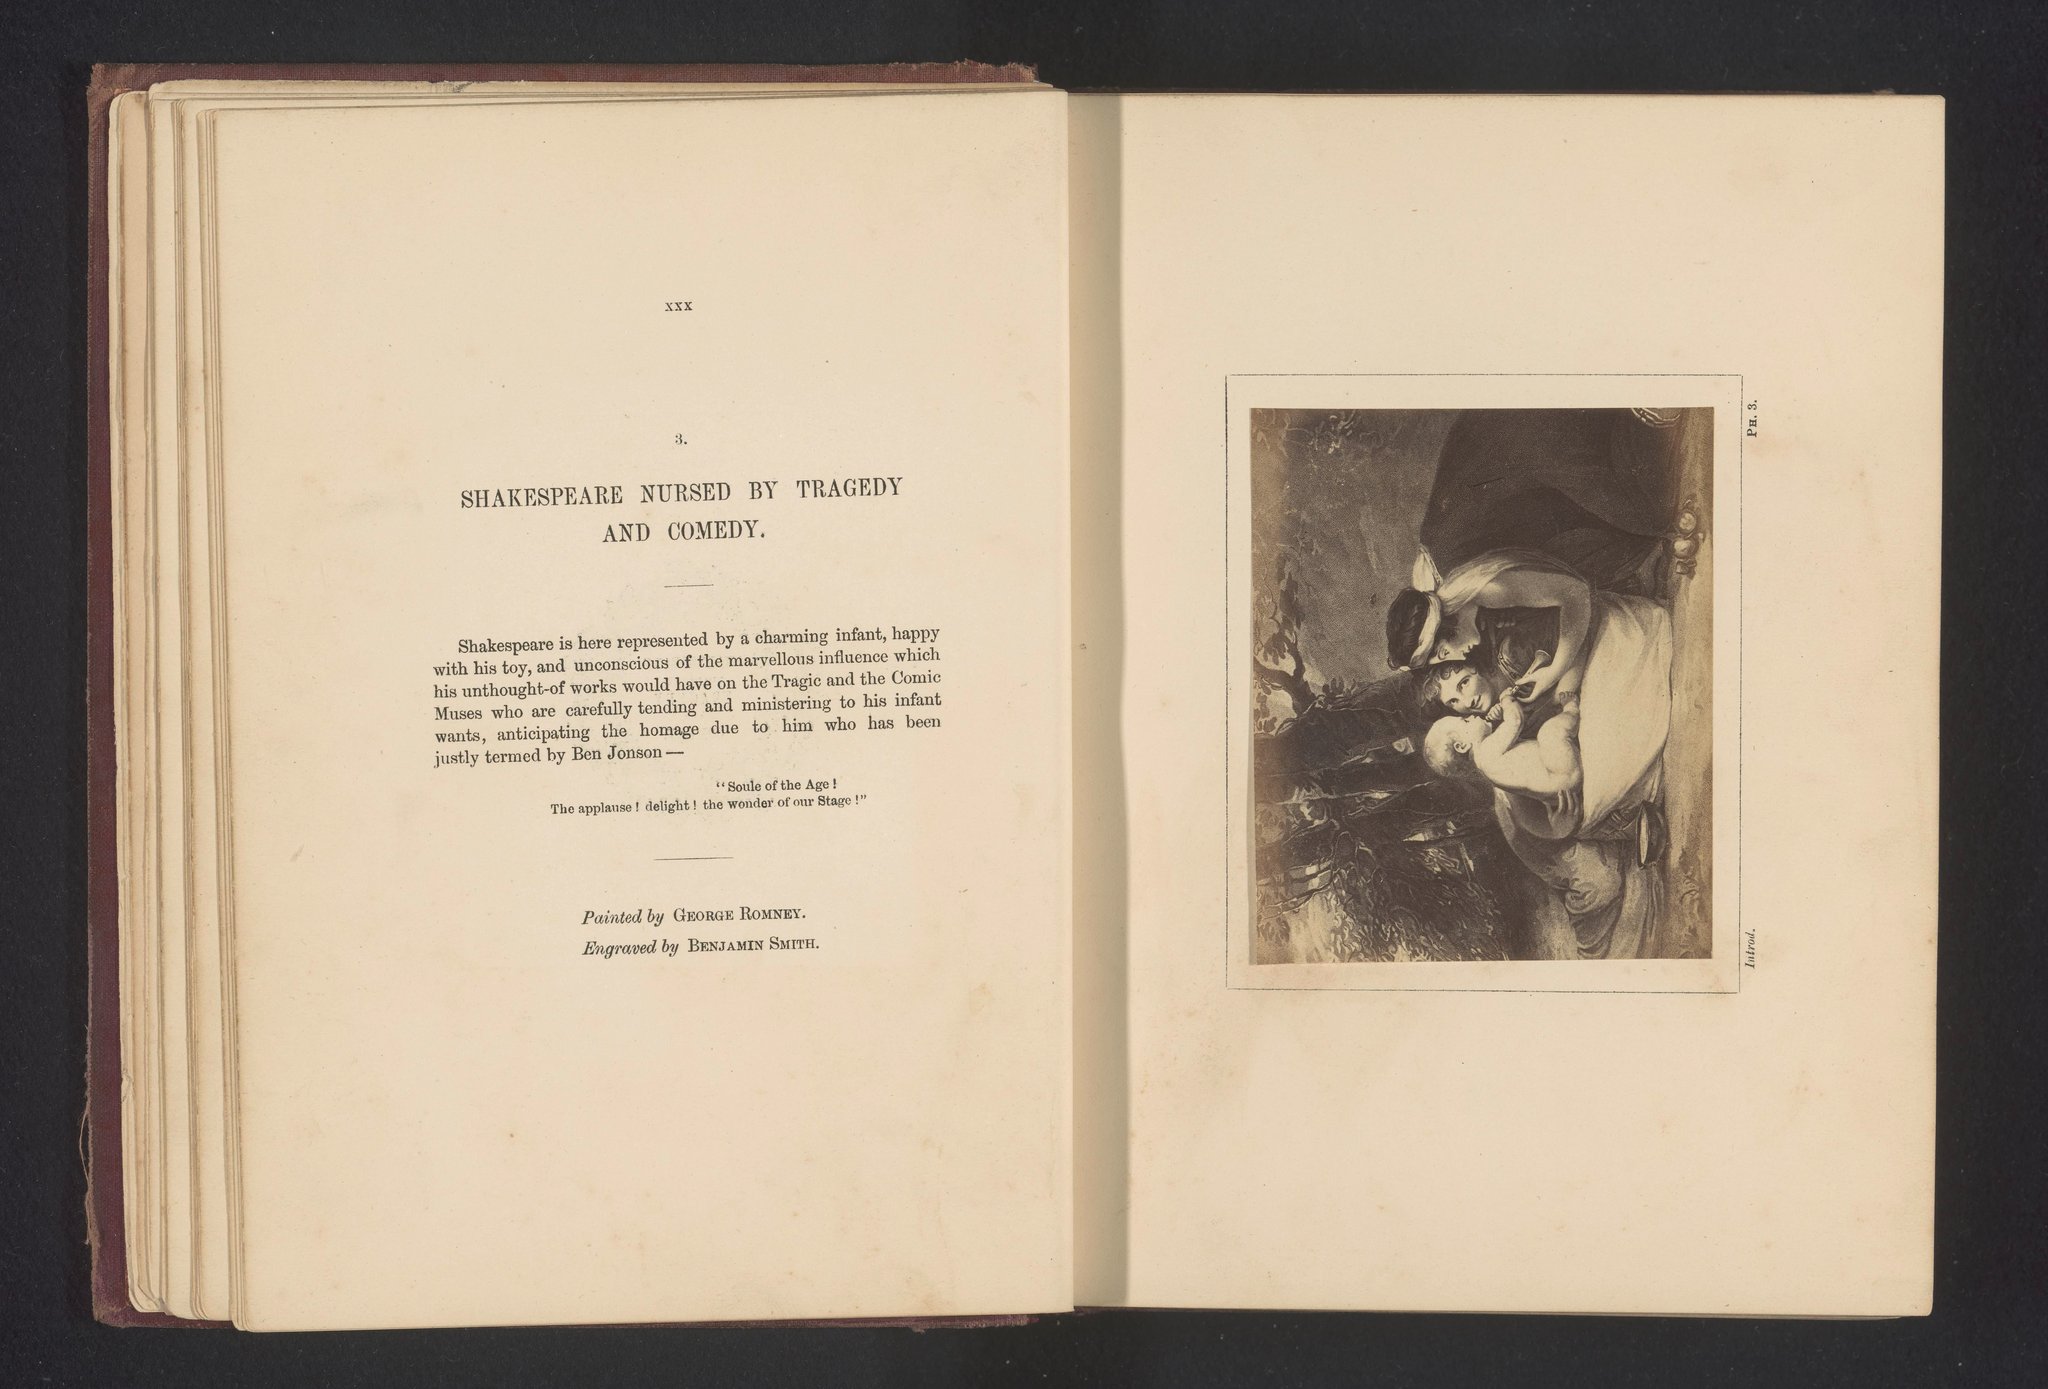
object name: page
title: Fotoreproductie van een prent naar een schilderij door George Romney, voorstellend William Shakespeare als baby die verzorgd wordt door vrouwelijke personificaties van tragedie en komedie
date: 1854-1867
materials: photographic support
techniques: albumen print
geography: london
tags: william shakespeare, 'comedia', 'comedia vecchia' (ripa), infant, baby, 'tragedia' (ripa)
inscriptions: number: ‘Introd. Ph. 3.’